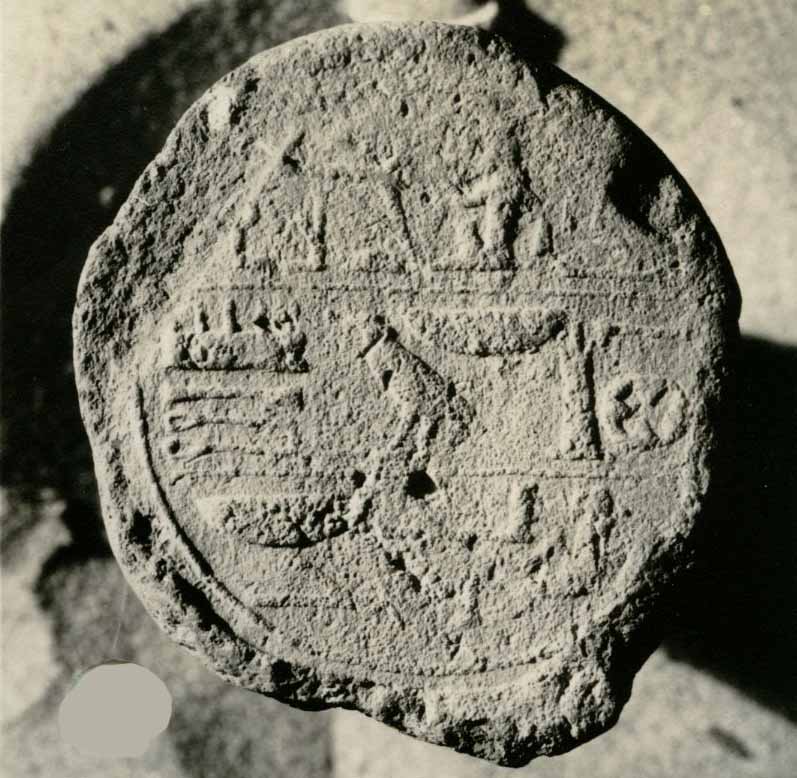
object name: cone, nebwa, overseer of work, montu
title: Funerary Cone of the Overseer of Works of Montu Nebwa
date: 1550-1295 BCE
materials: pottery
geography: egypt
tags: hieroglyphs